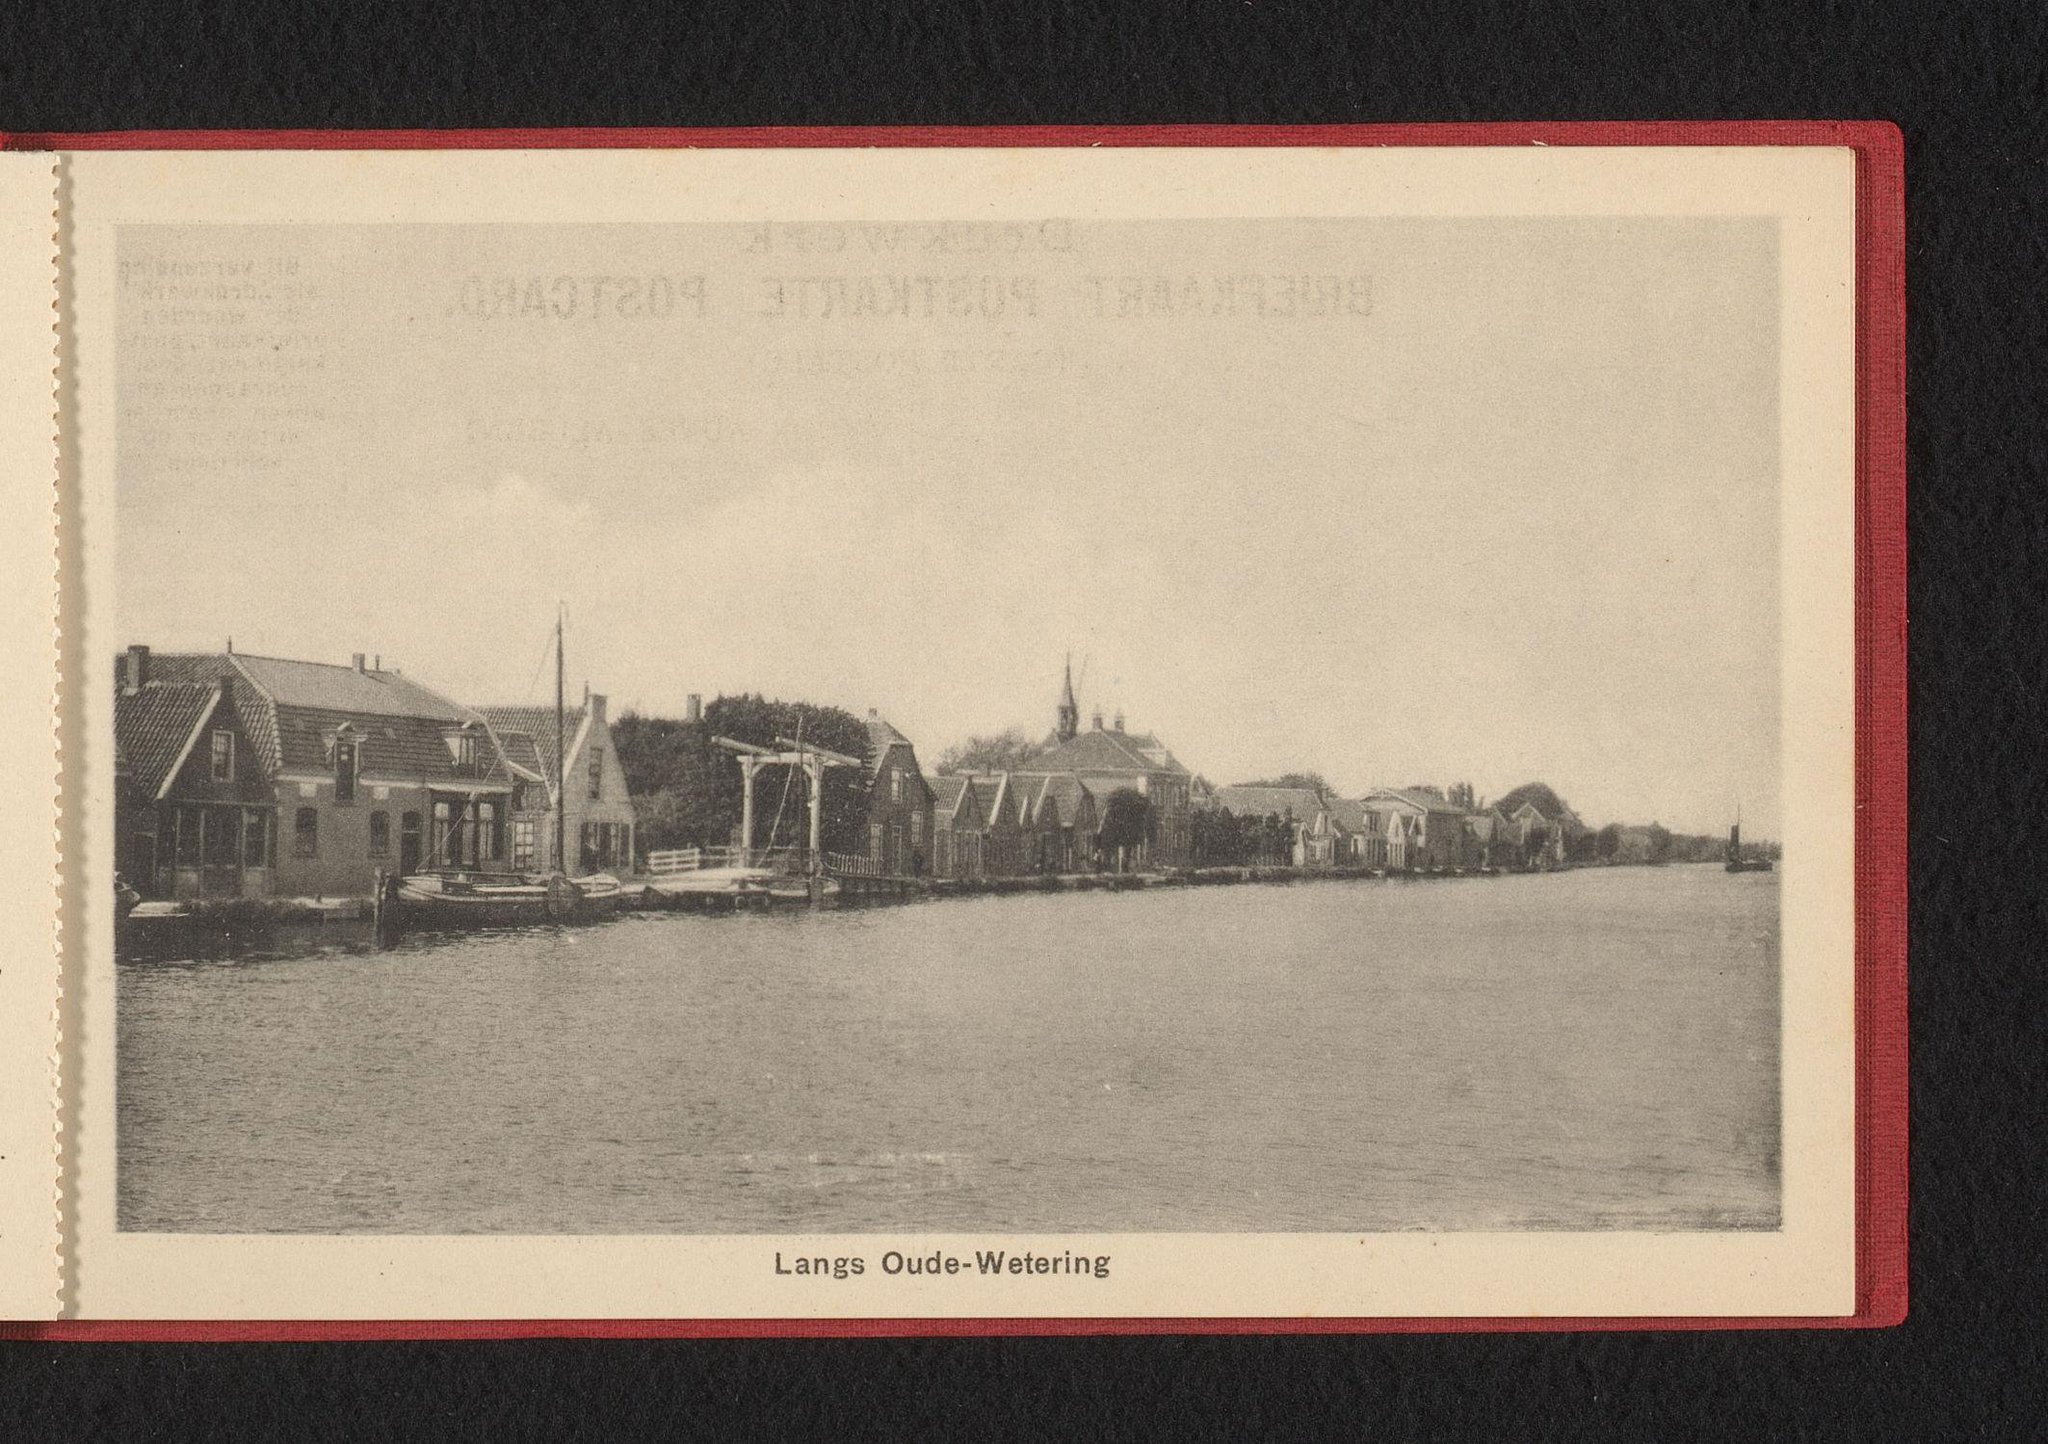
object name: ansichtkaart, prentbriefkaart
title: Langs Oude-Wetering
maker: Anonymous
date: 1906-1915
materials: cardboard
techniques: photograph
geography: amsterdam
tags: river, street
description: Prentbriefkaart maakt deel uit van een album.